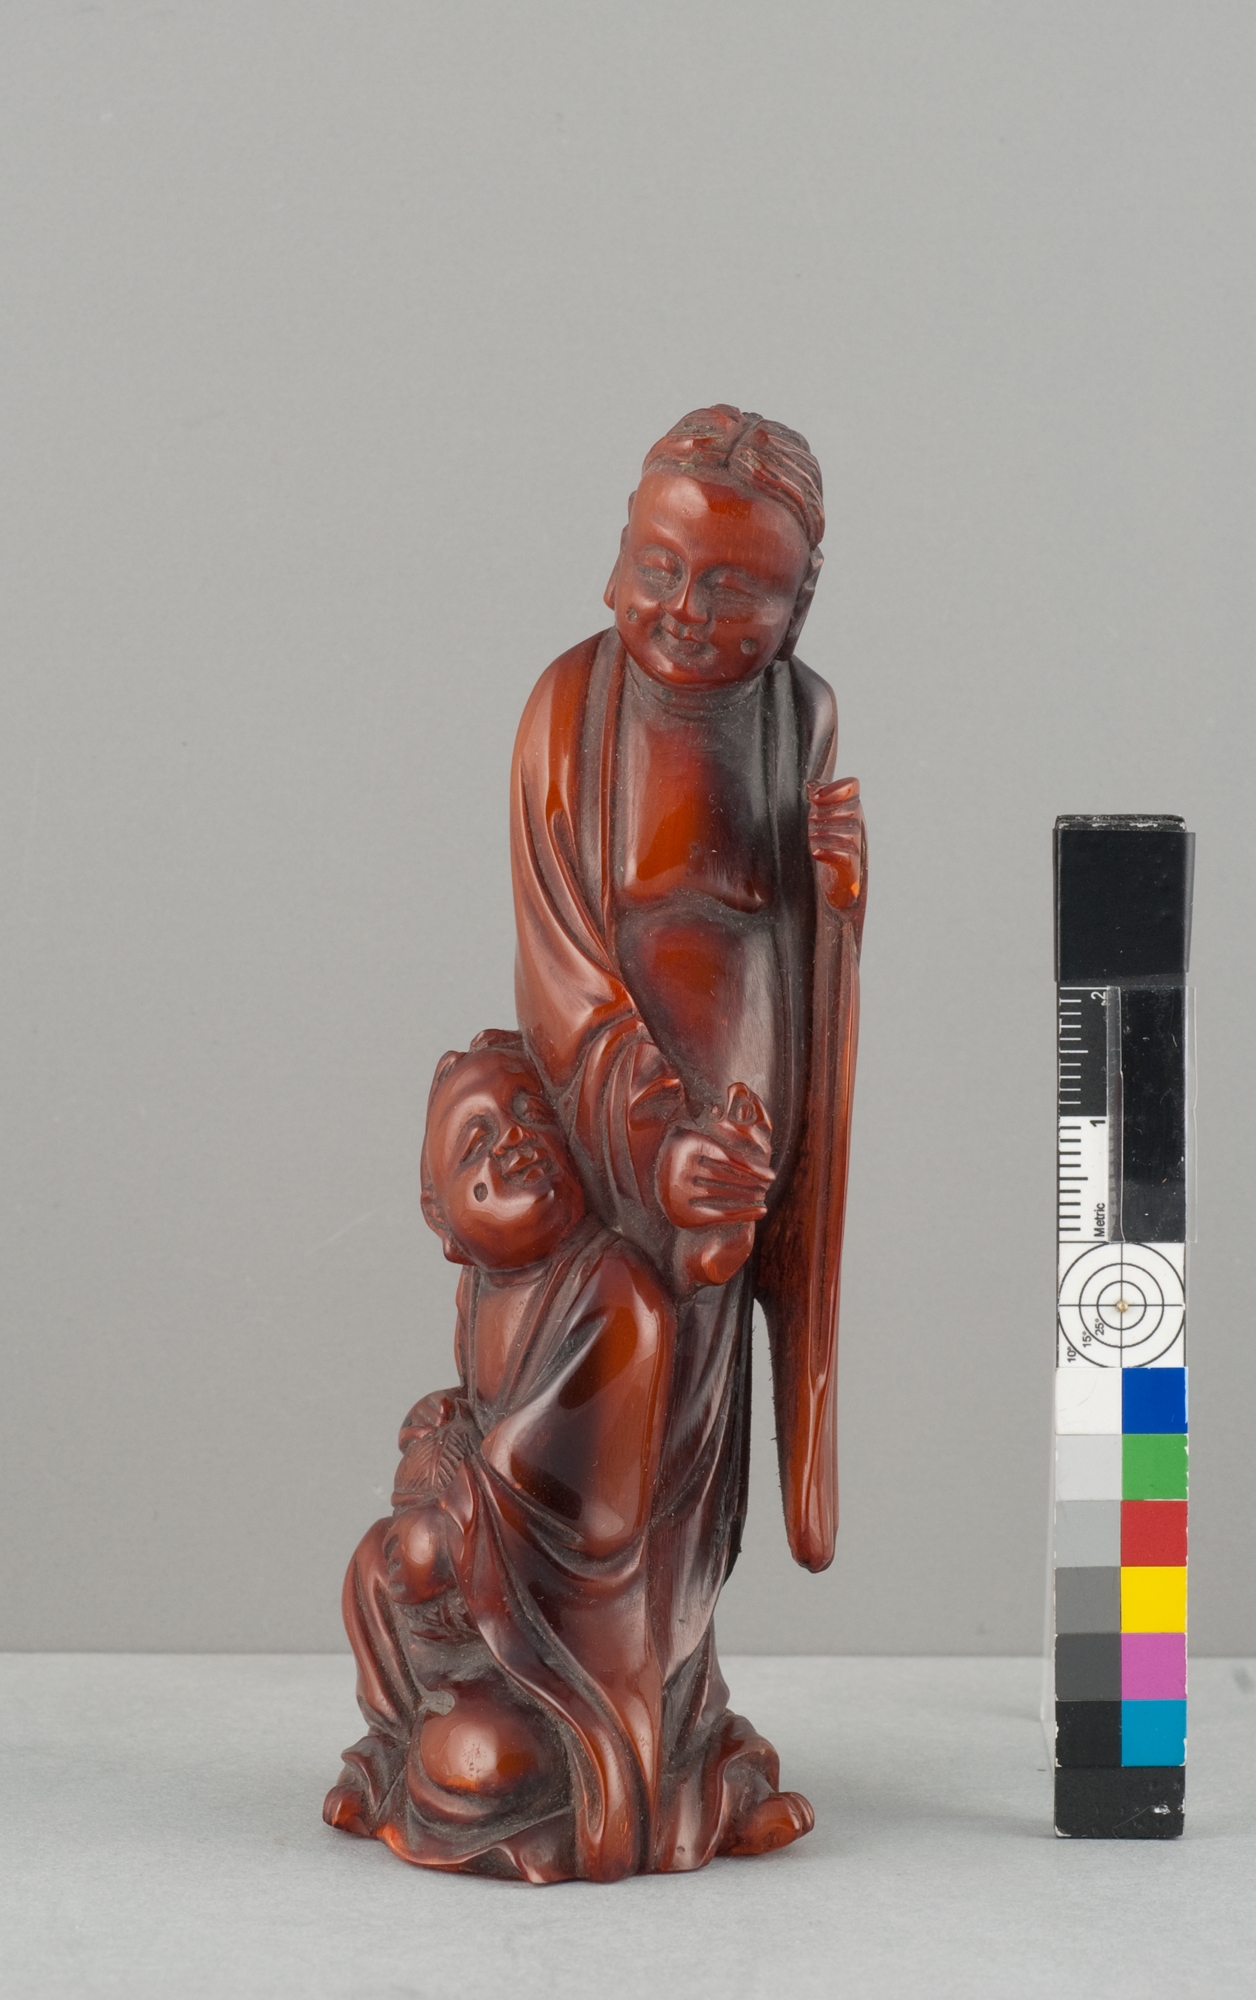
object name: figure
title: Figures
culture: chinese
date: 1701-1800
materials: amber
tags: men